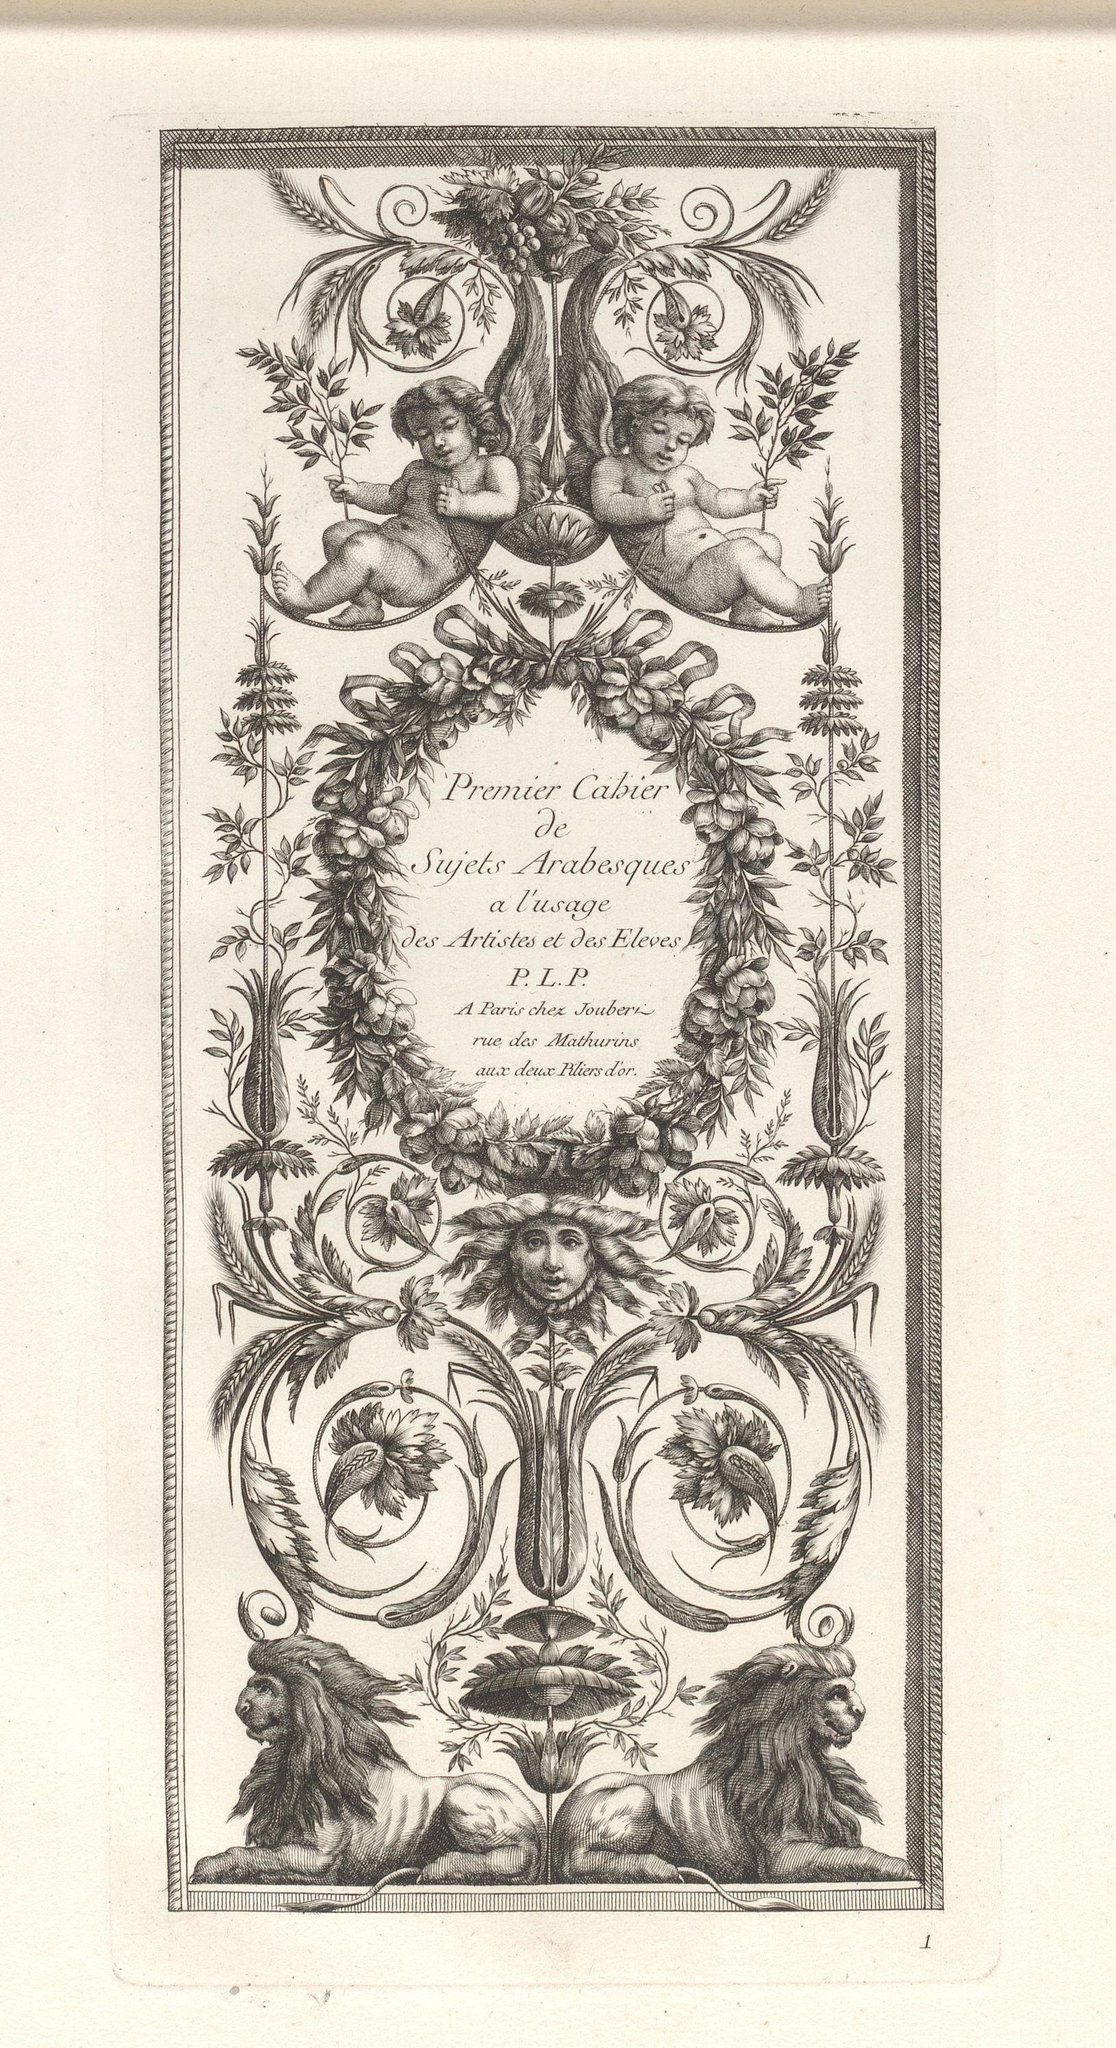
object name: album leaf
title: Arabesken, ontworpen door Pierre-Alexandre Le Prieur, tweeede serie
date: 1802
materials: paper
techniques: engraving, etching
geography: paris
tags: ornament derived from animal forms, ornament ~ arabesque, ornament derived from plant forms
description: Doordat dit album bestaat uit meerdere, deels eerder uitgegeven prentreeksen, is de datering niet consequent. Het geheel is op de titelpagina gedateerd op 1802. Deze reeks is niet afzonderlijk gedateerd. De serietitel voor het gehele werk is "Recueil d'arabesques, contenant les loges du Vatican". De andere serietitel is de titel van de specifieke reeks binnen het geheel.